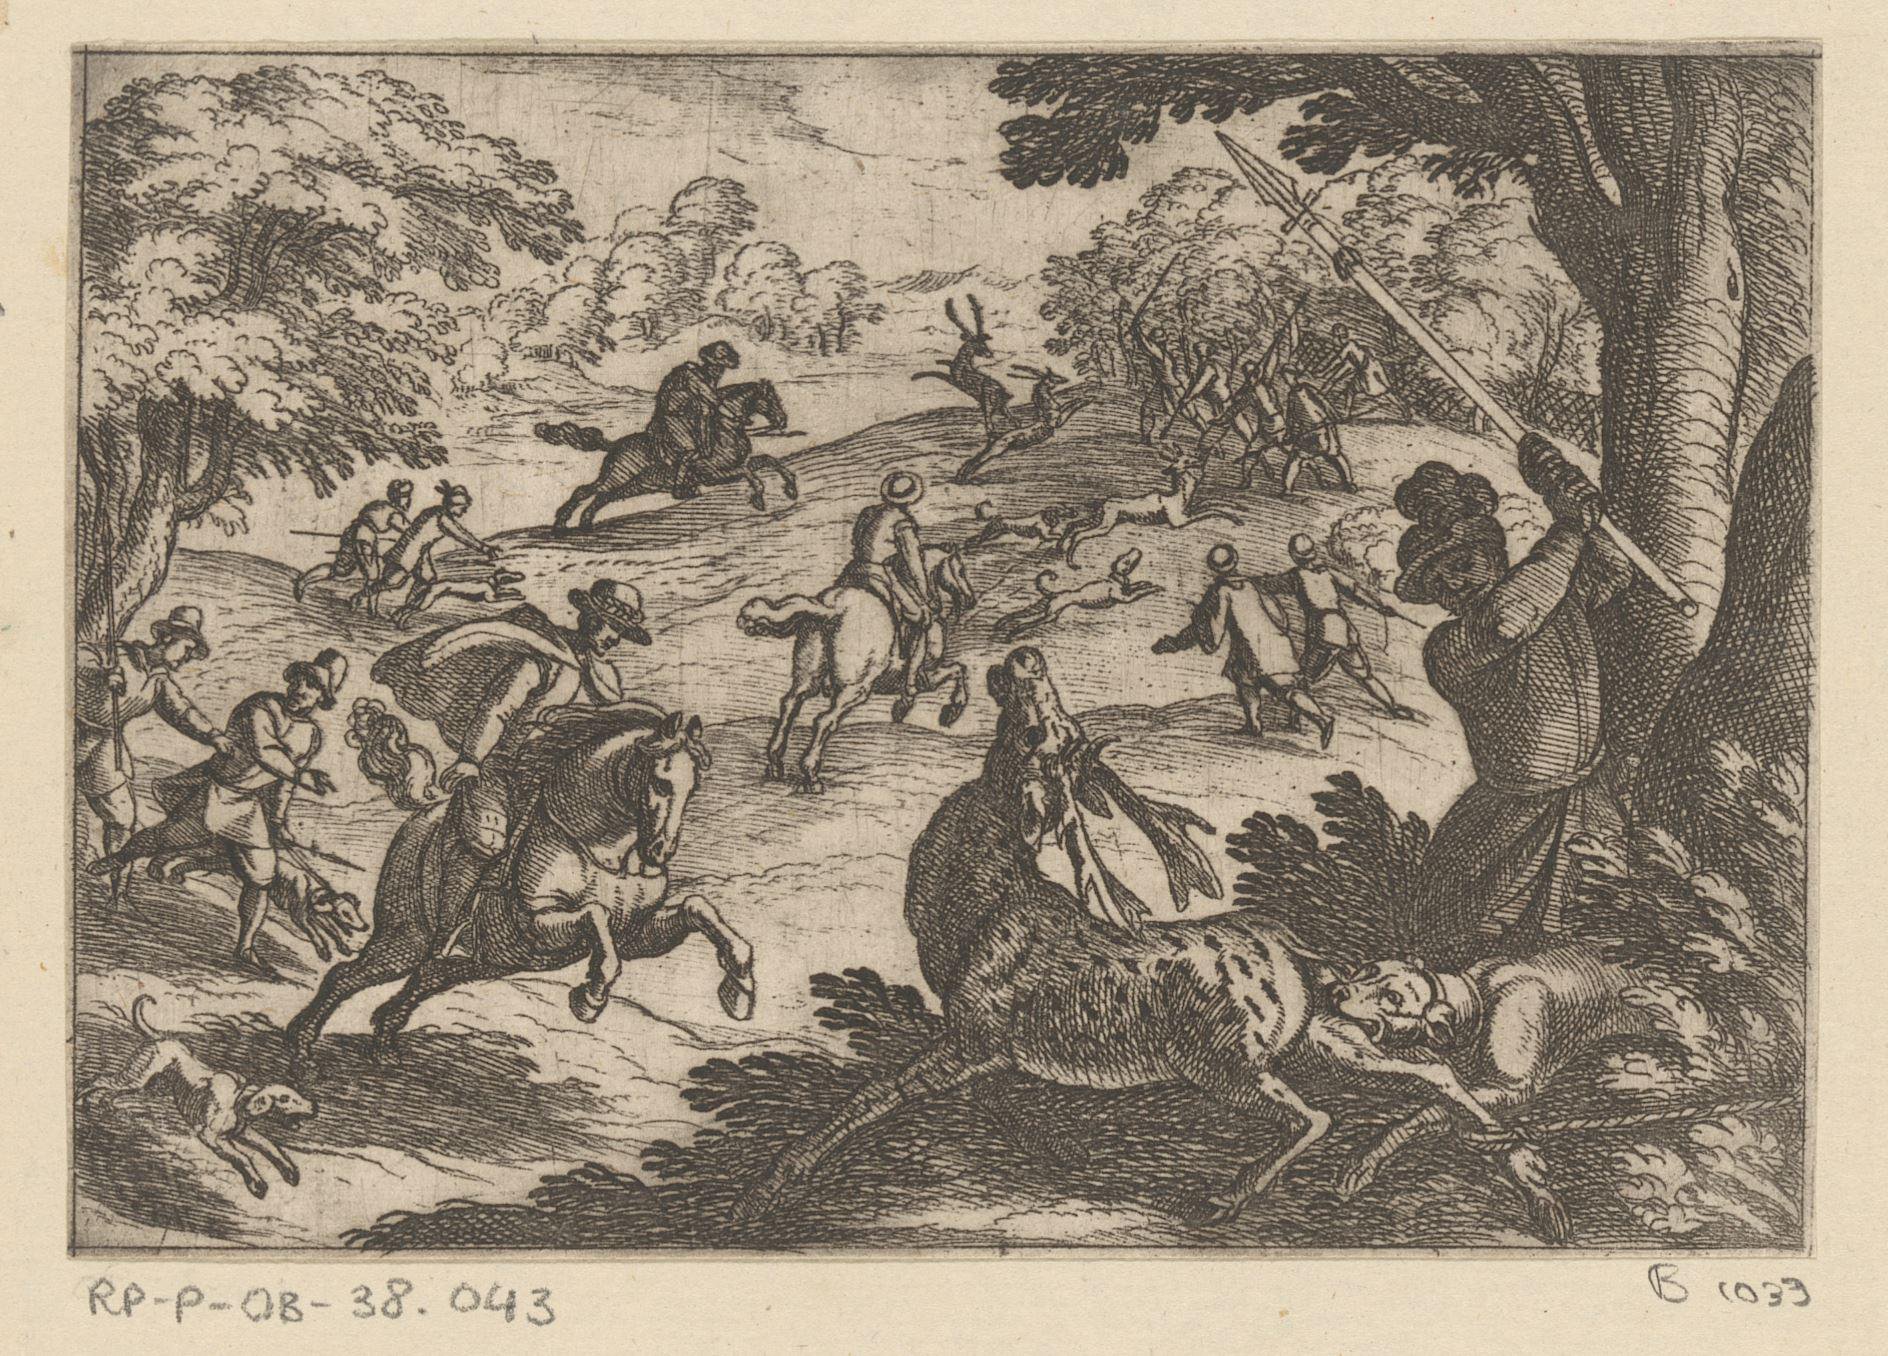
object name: print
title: Jacht op herten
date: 1598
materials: paper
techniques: etching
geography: vatican city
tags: stag-hunting, hunter, hunters hunting (n.b.: in 1988-1990 this notation denoted the concept of 43c11421 'hunters resting during the hunt')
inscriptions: collector's mark: Lugt 240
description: Deze prent maakt deel uit van een reeks van 45 jachtscènes (+ titelprent en opdracht).